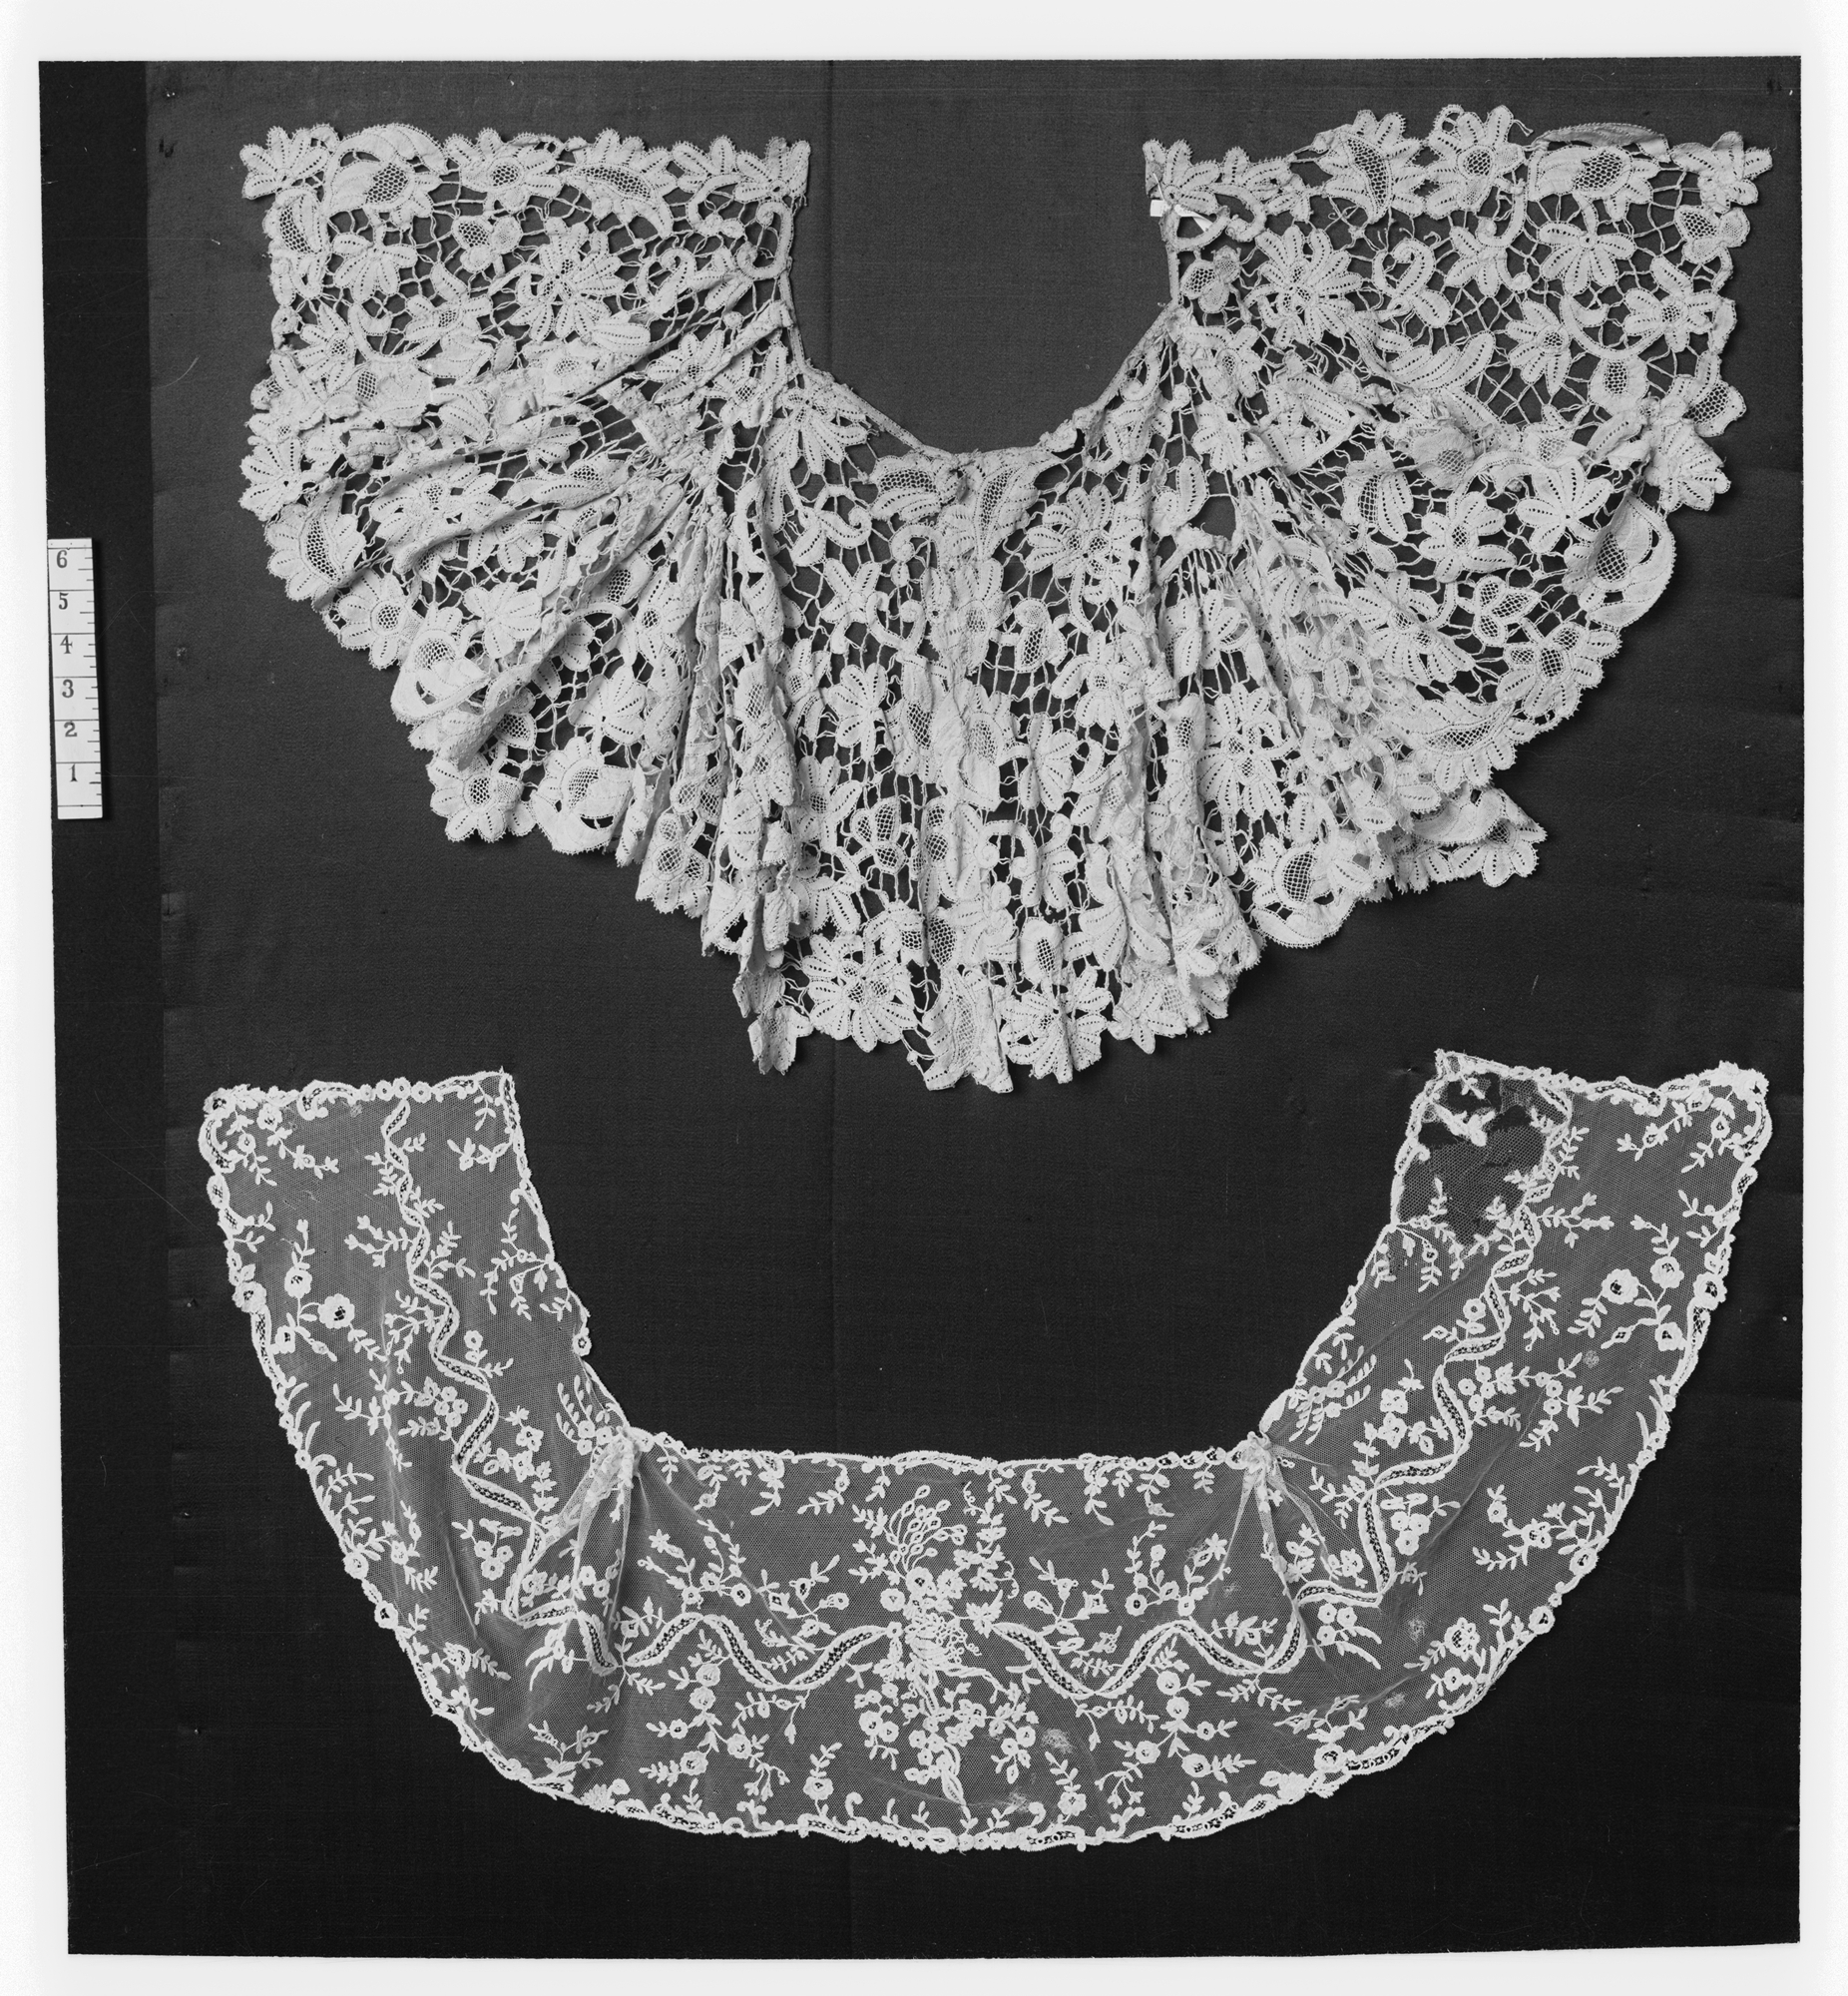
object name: collar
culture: belgian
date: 1825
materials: silk